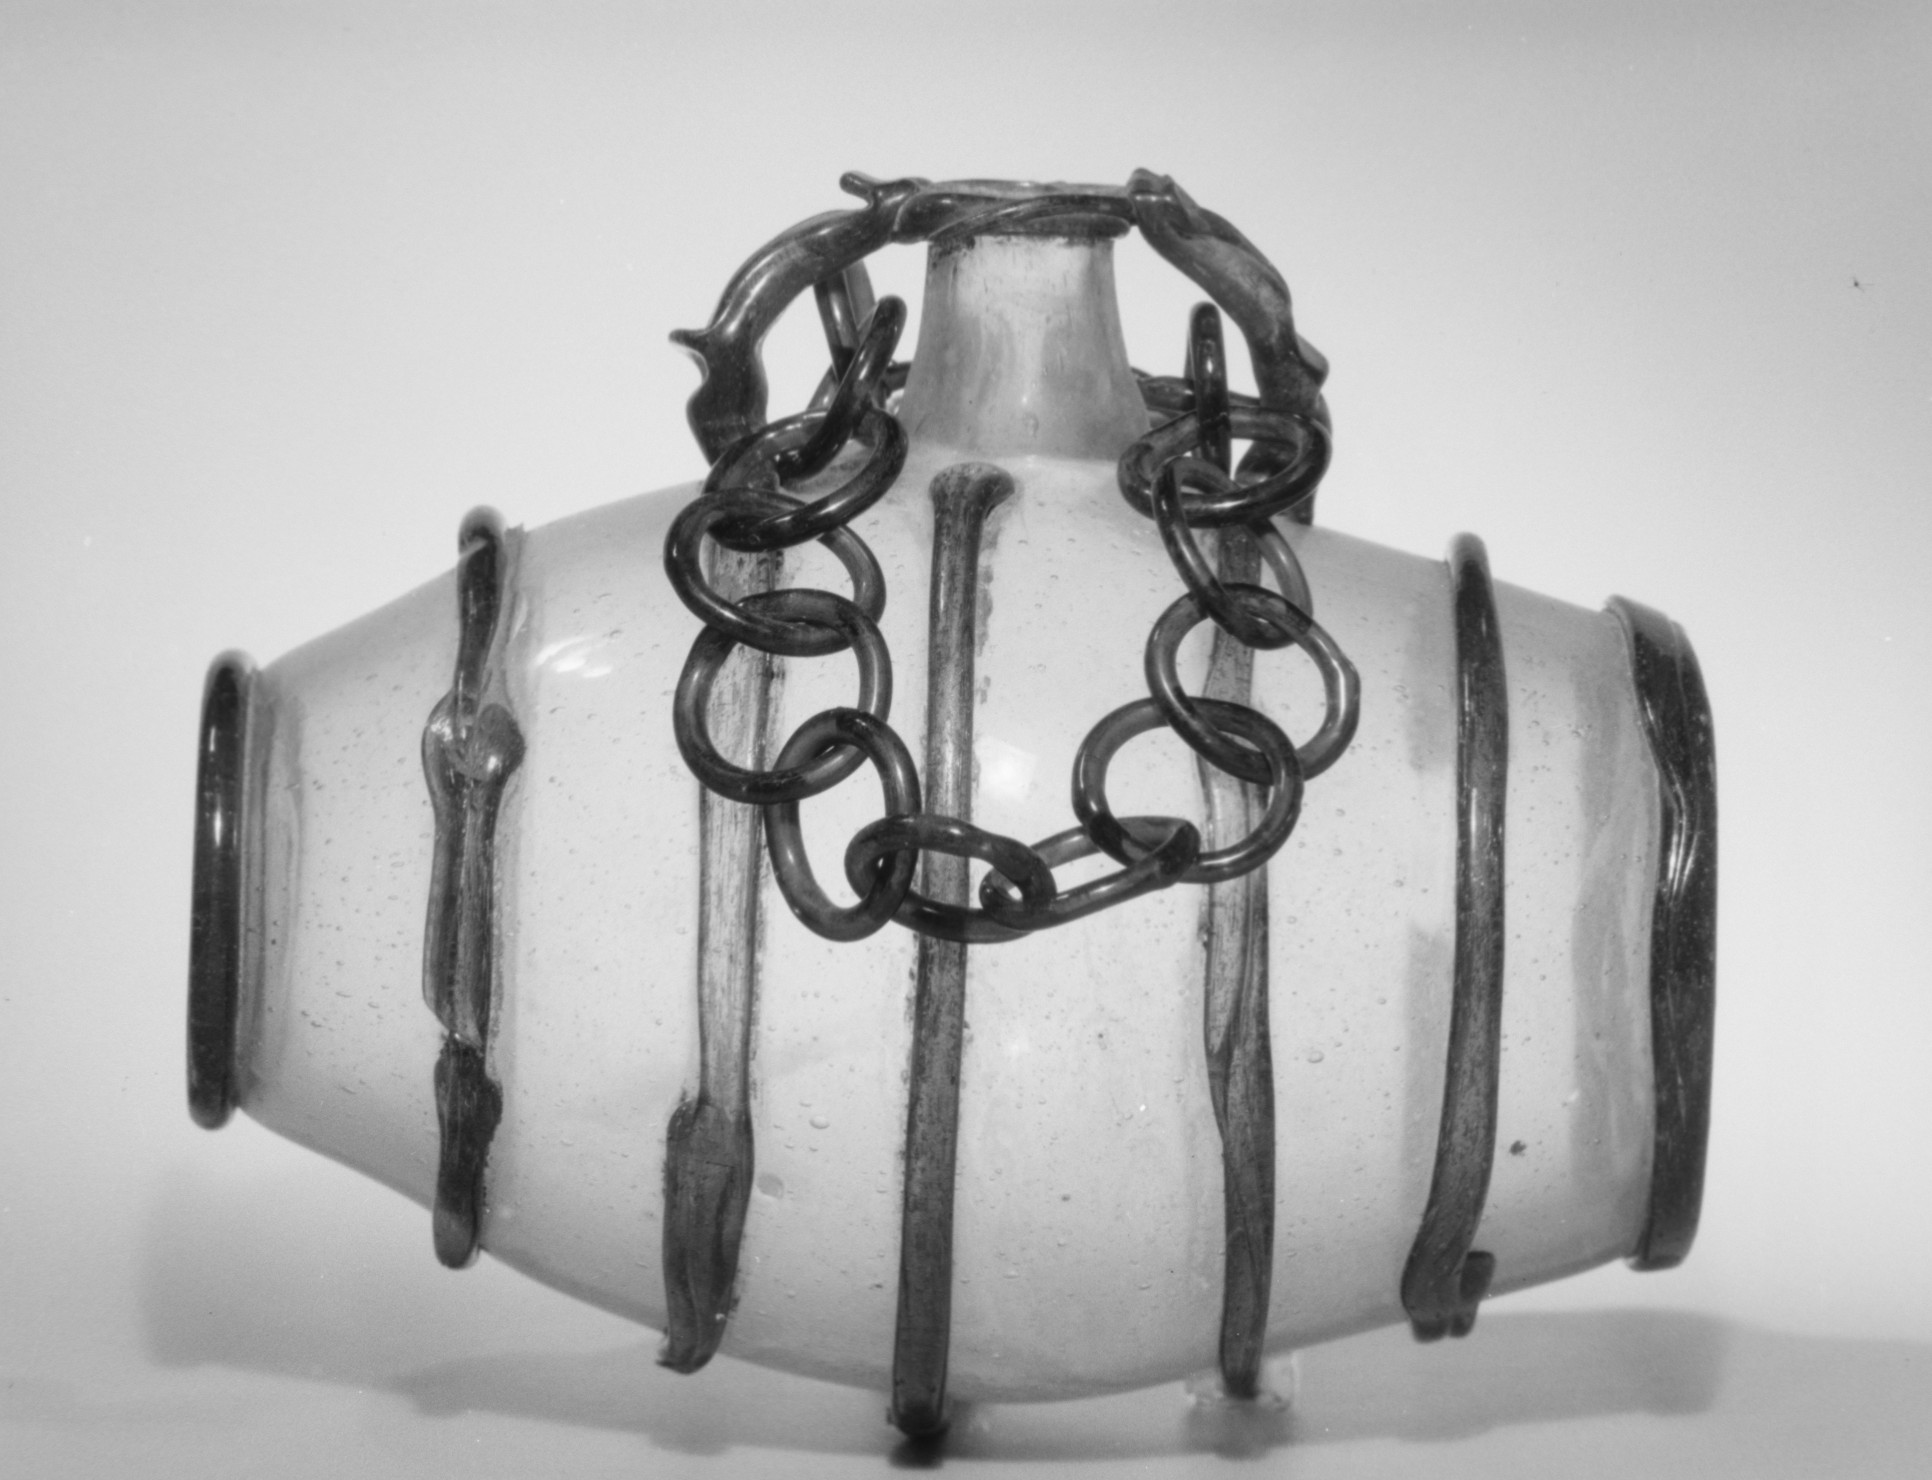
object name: flask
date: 1601-1700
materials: glass